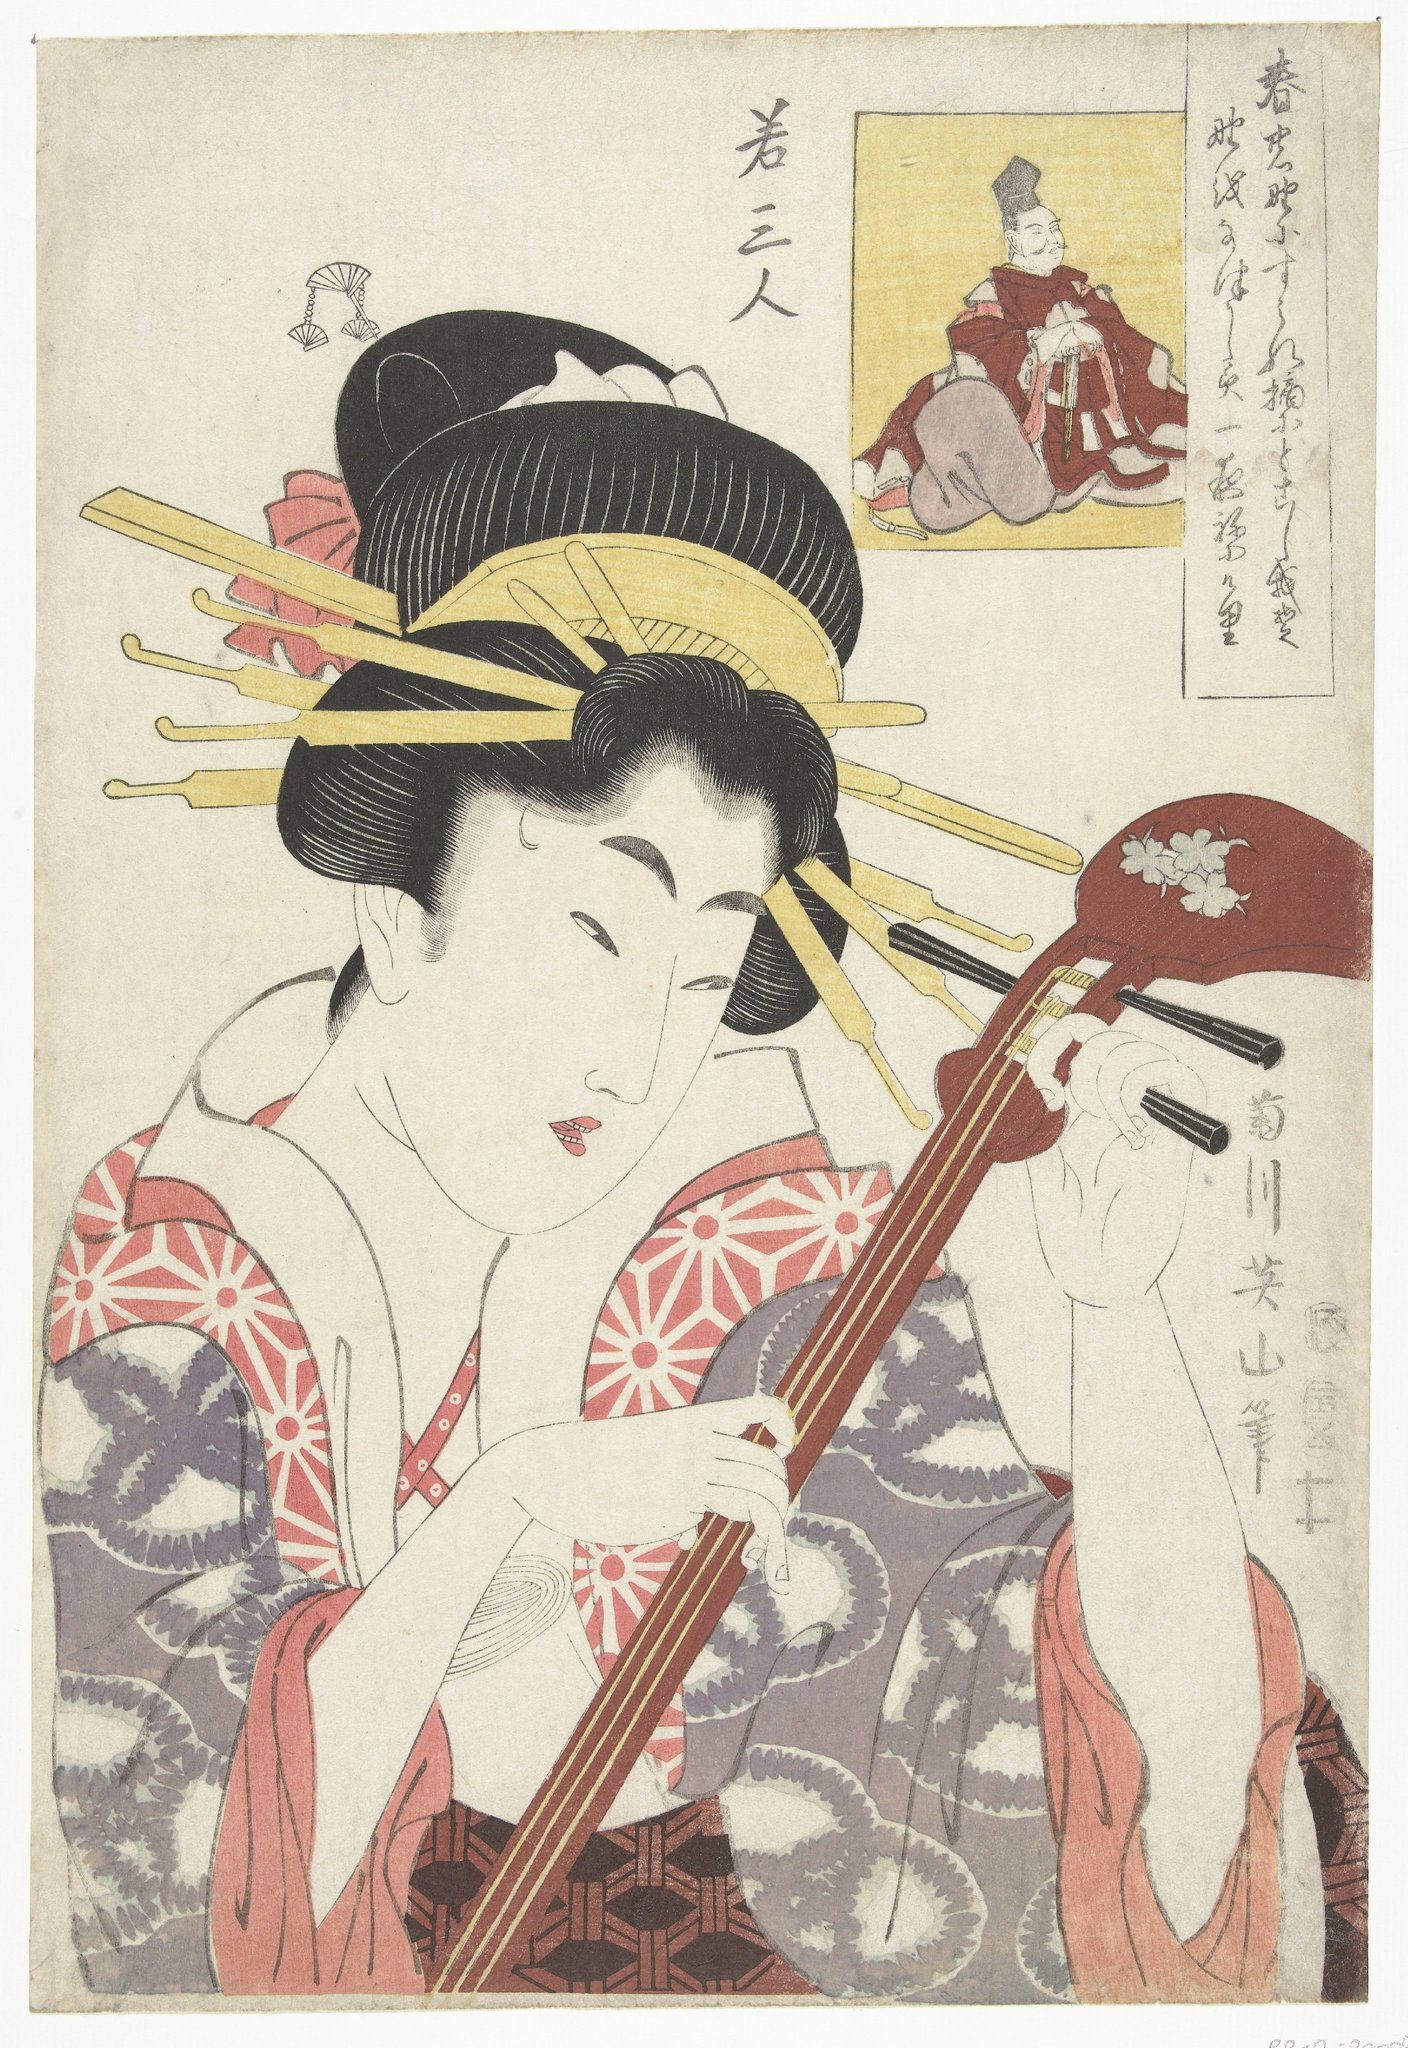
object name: print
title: Vrouw met shamisen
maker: kikugawa eizan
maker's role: painter, print maker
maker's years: 1787-1867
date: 1805-1808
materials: paper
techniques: woodcut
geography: japan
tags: writer, poet, author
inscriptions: date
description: Busteportret van shamisen stemmende vrouw; rechtsboven vierkant cartouche met afbeelding van de dichter Yamabe no Akihito (achtste eeuw) tegen gele achtergrond.